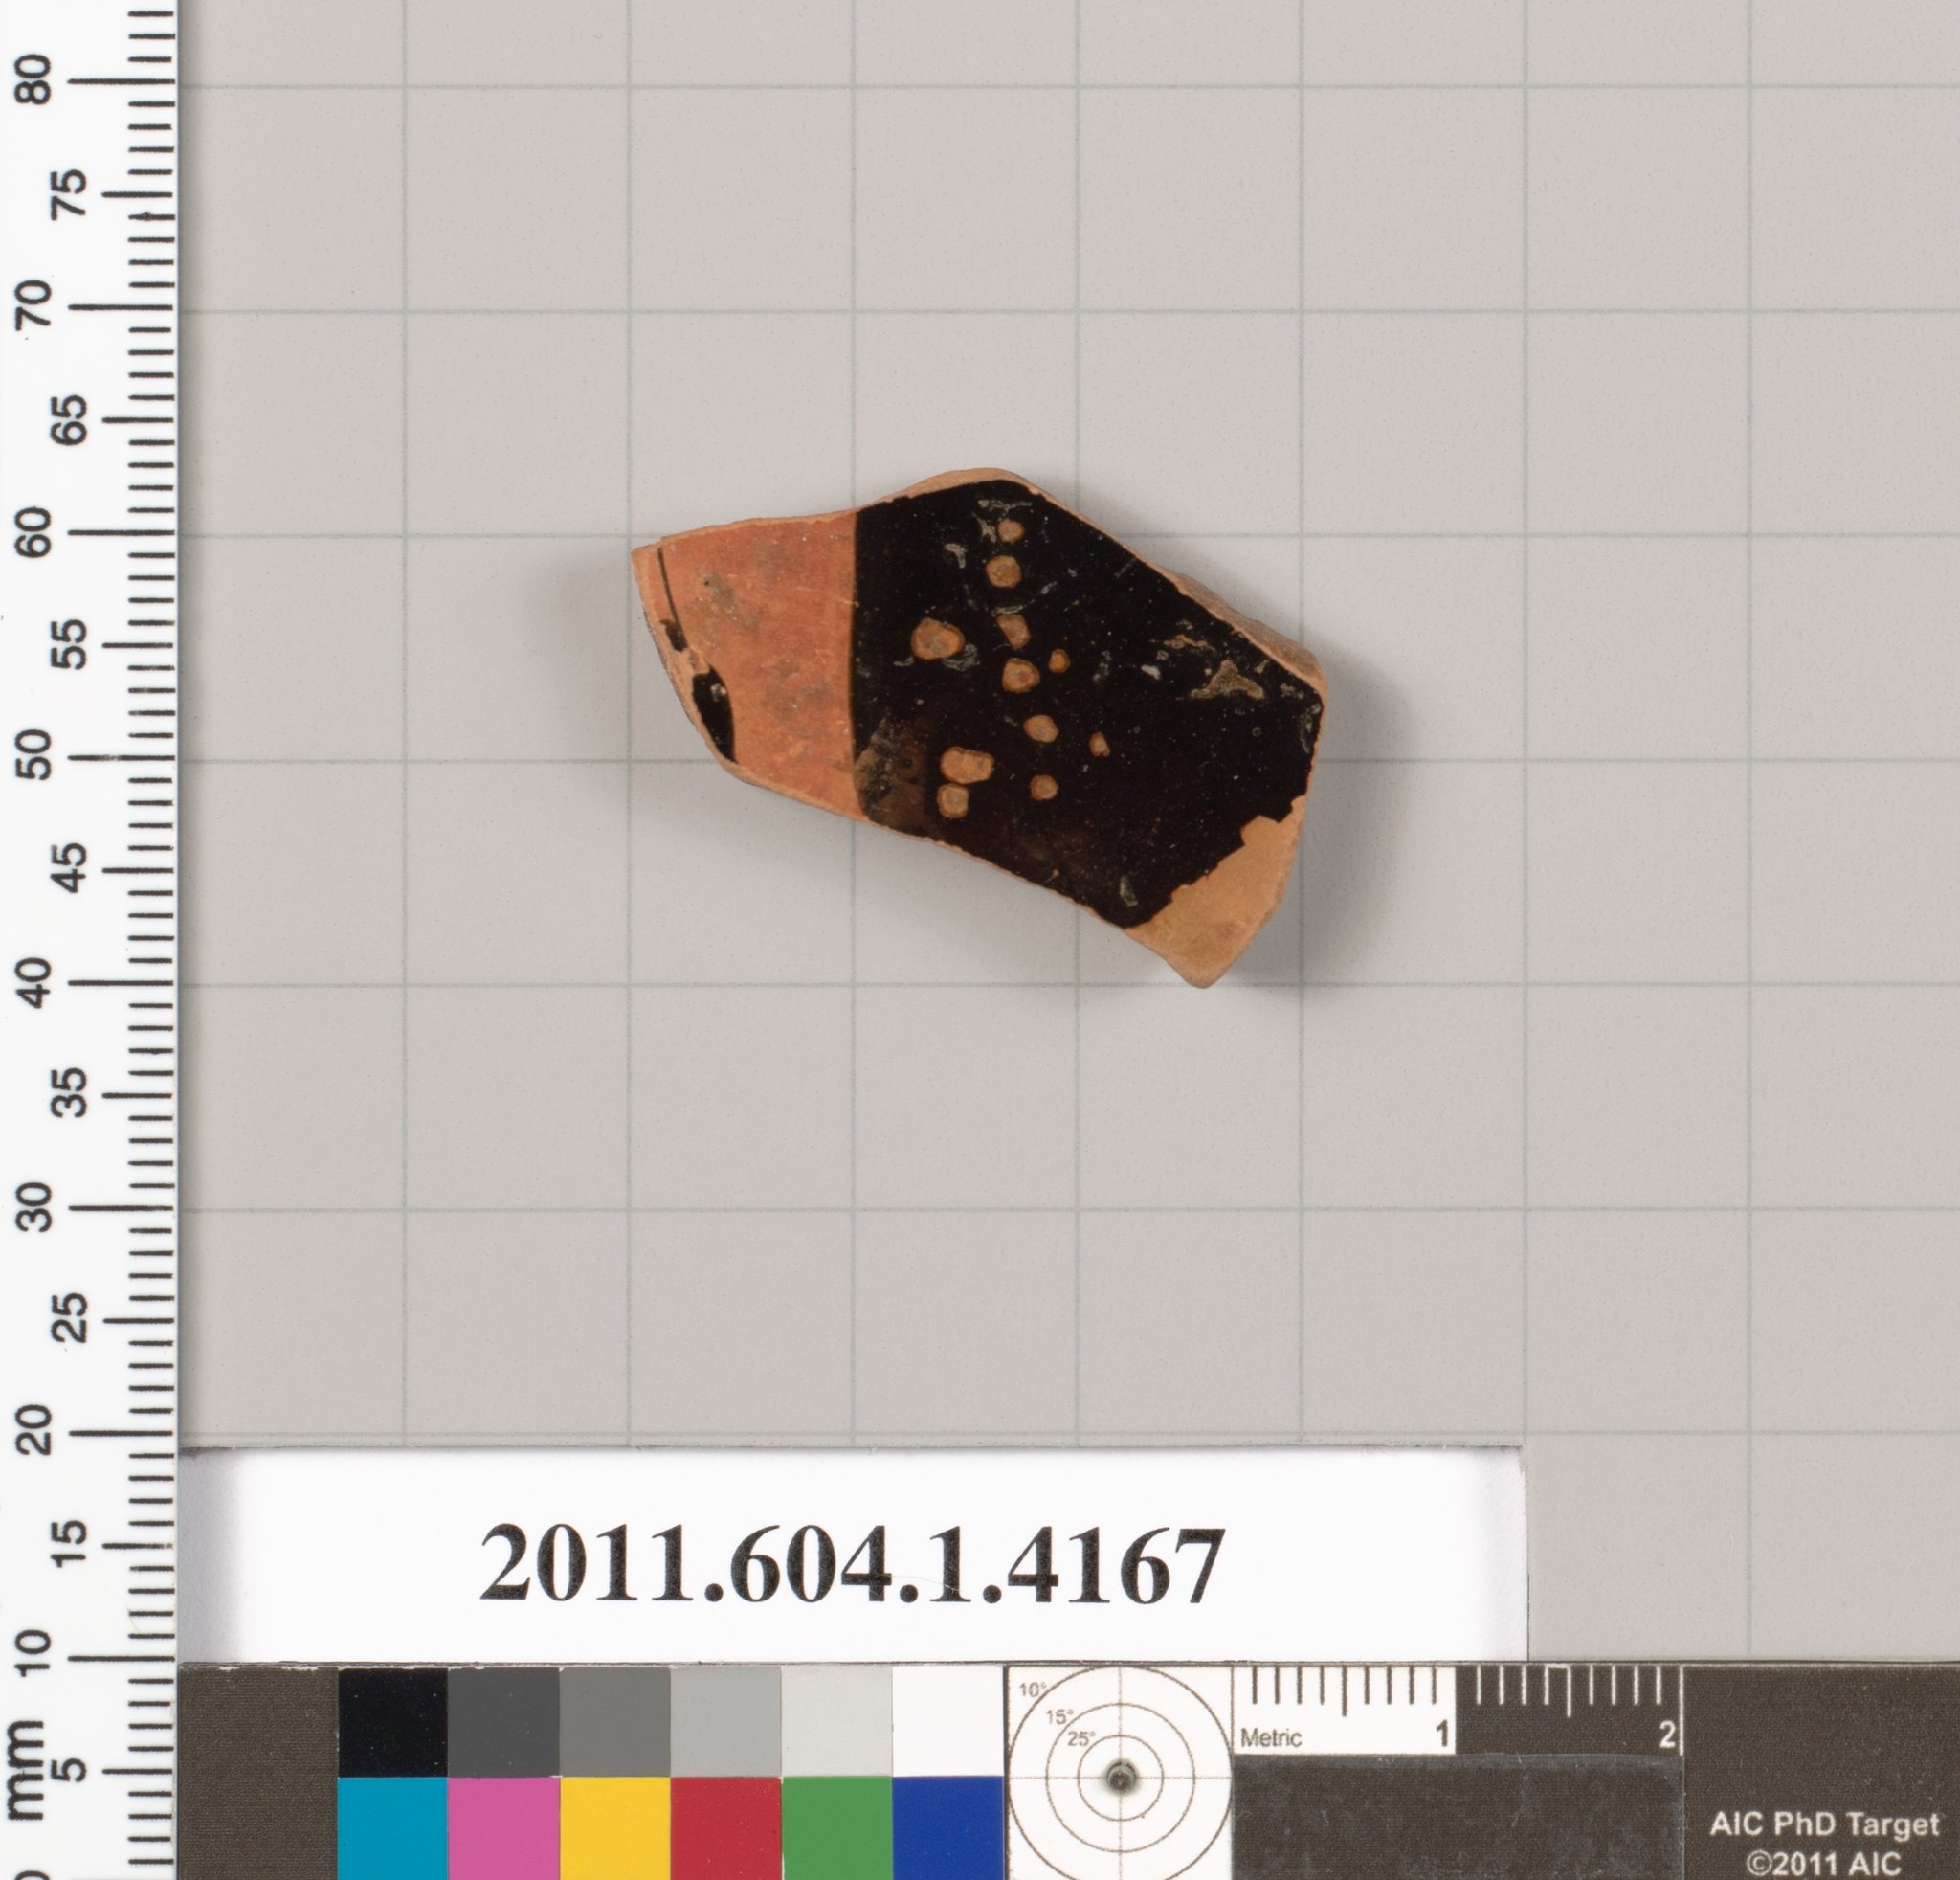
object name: kylix fragment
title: Terracotta fragment of a kylix (drinking cup)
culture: greek, attic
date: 500-480 BCE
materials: terracotta